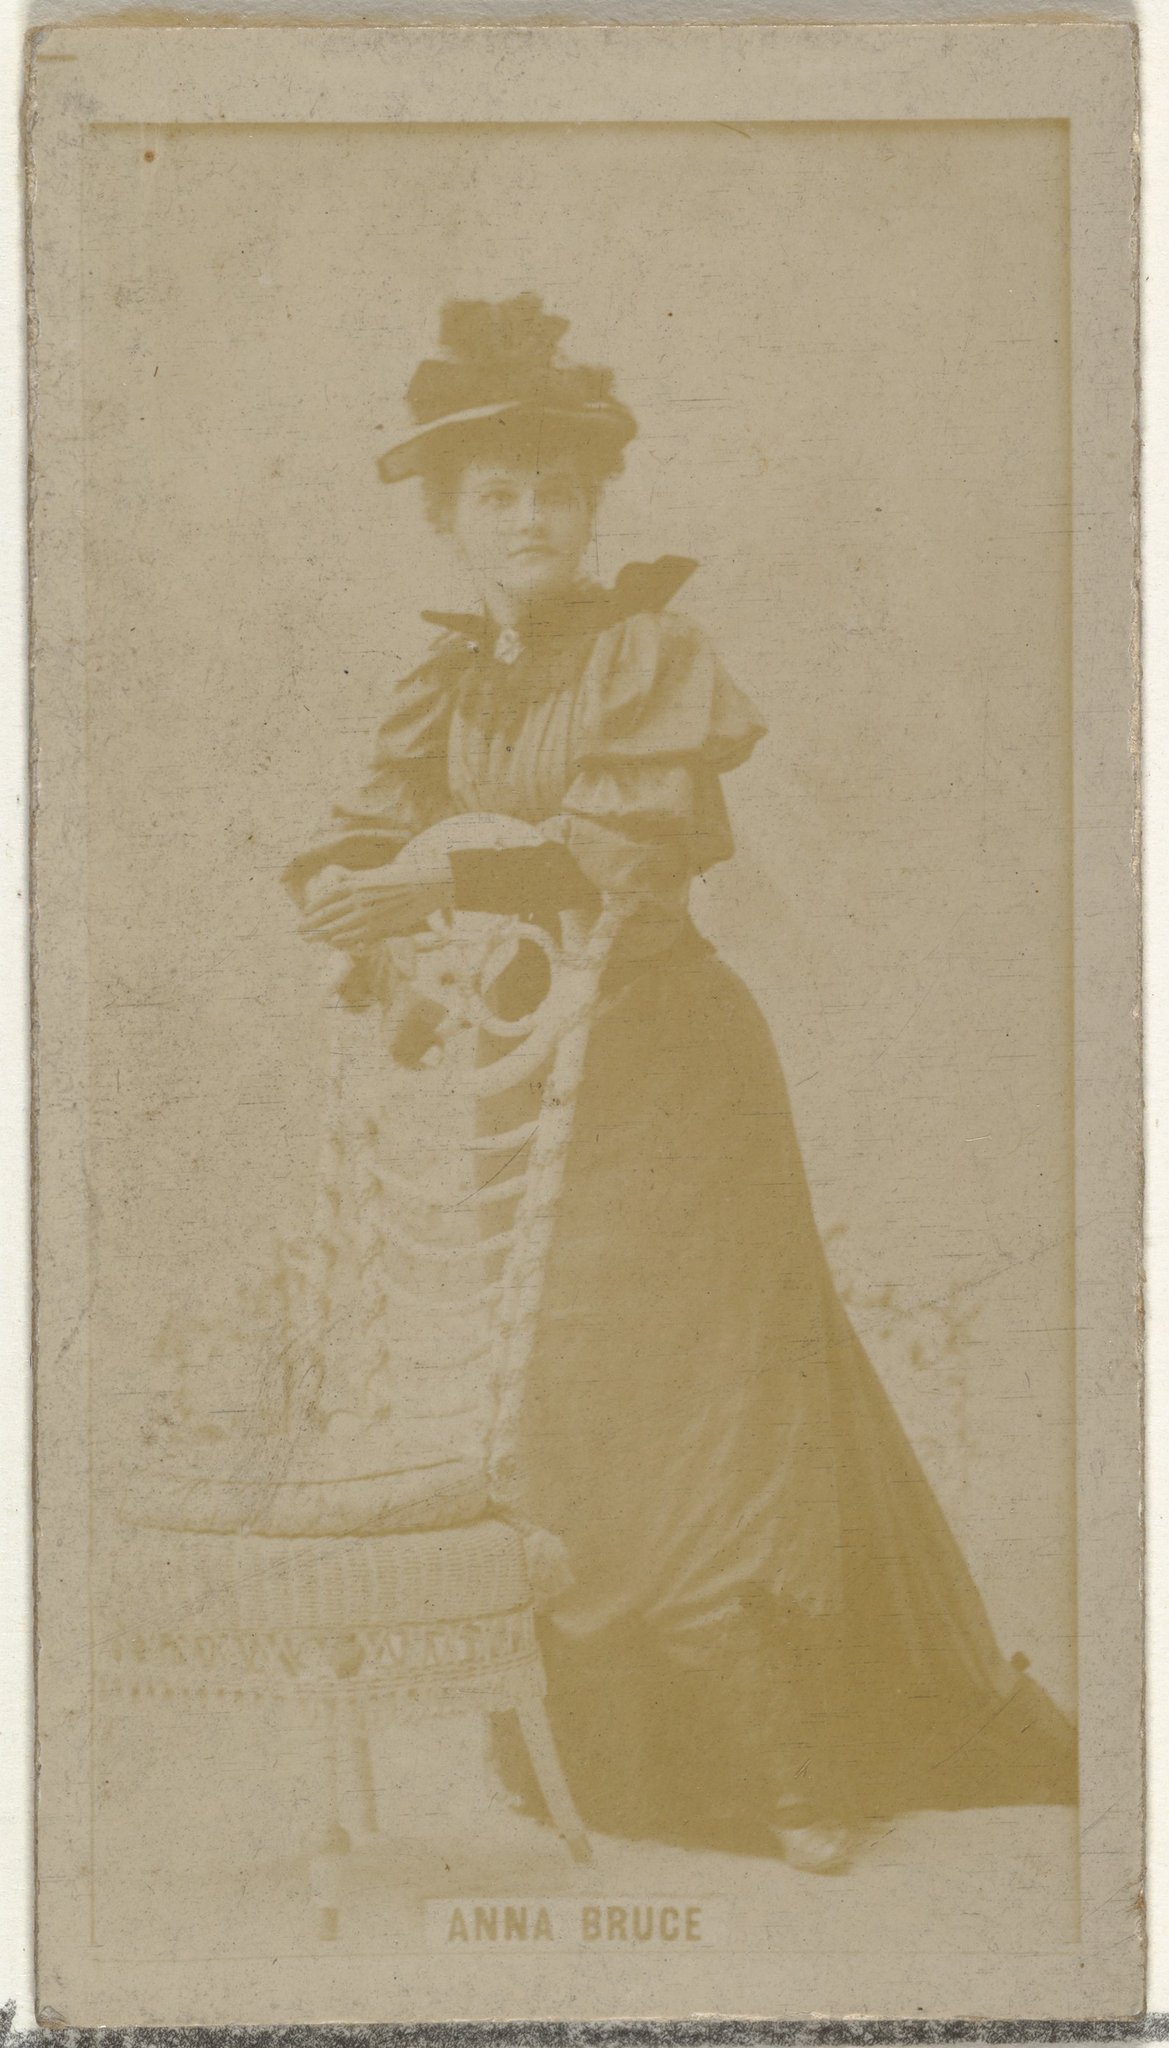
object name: photograph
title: Anna Bruce, from the Actors and Actresses series (N145-8) issued by Duke Sons & Co. to promote Duke Cigarettes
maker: w. duke, sons & co.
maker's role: publisher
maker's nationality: american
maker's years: 1870-1920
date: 1891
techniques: albumen silver print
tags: portraits,women,actresses